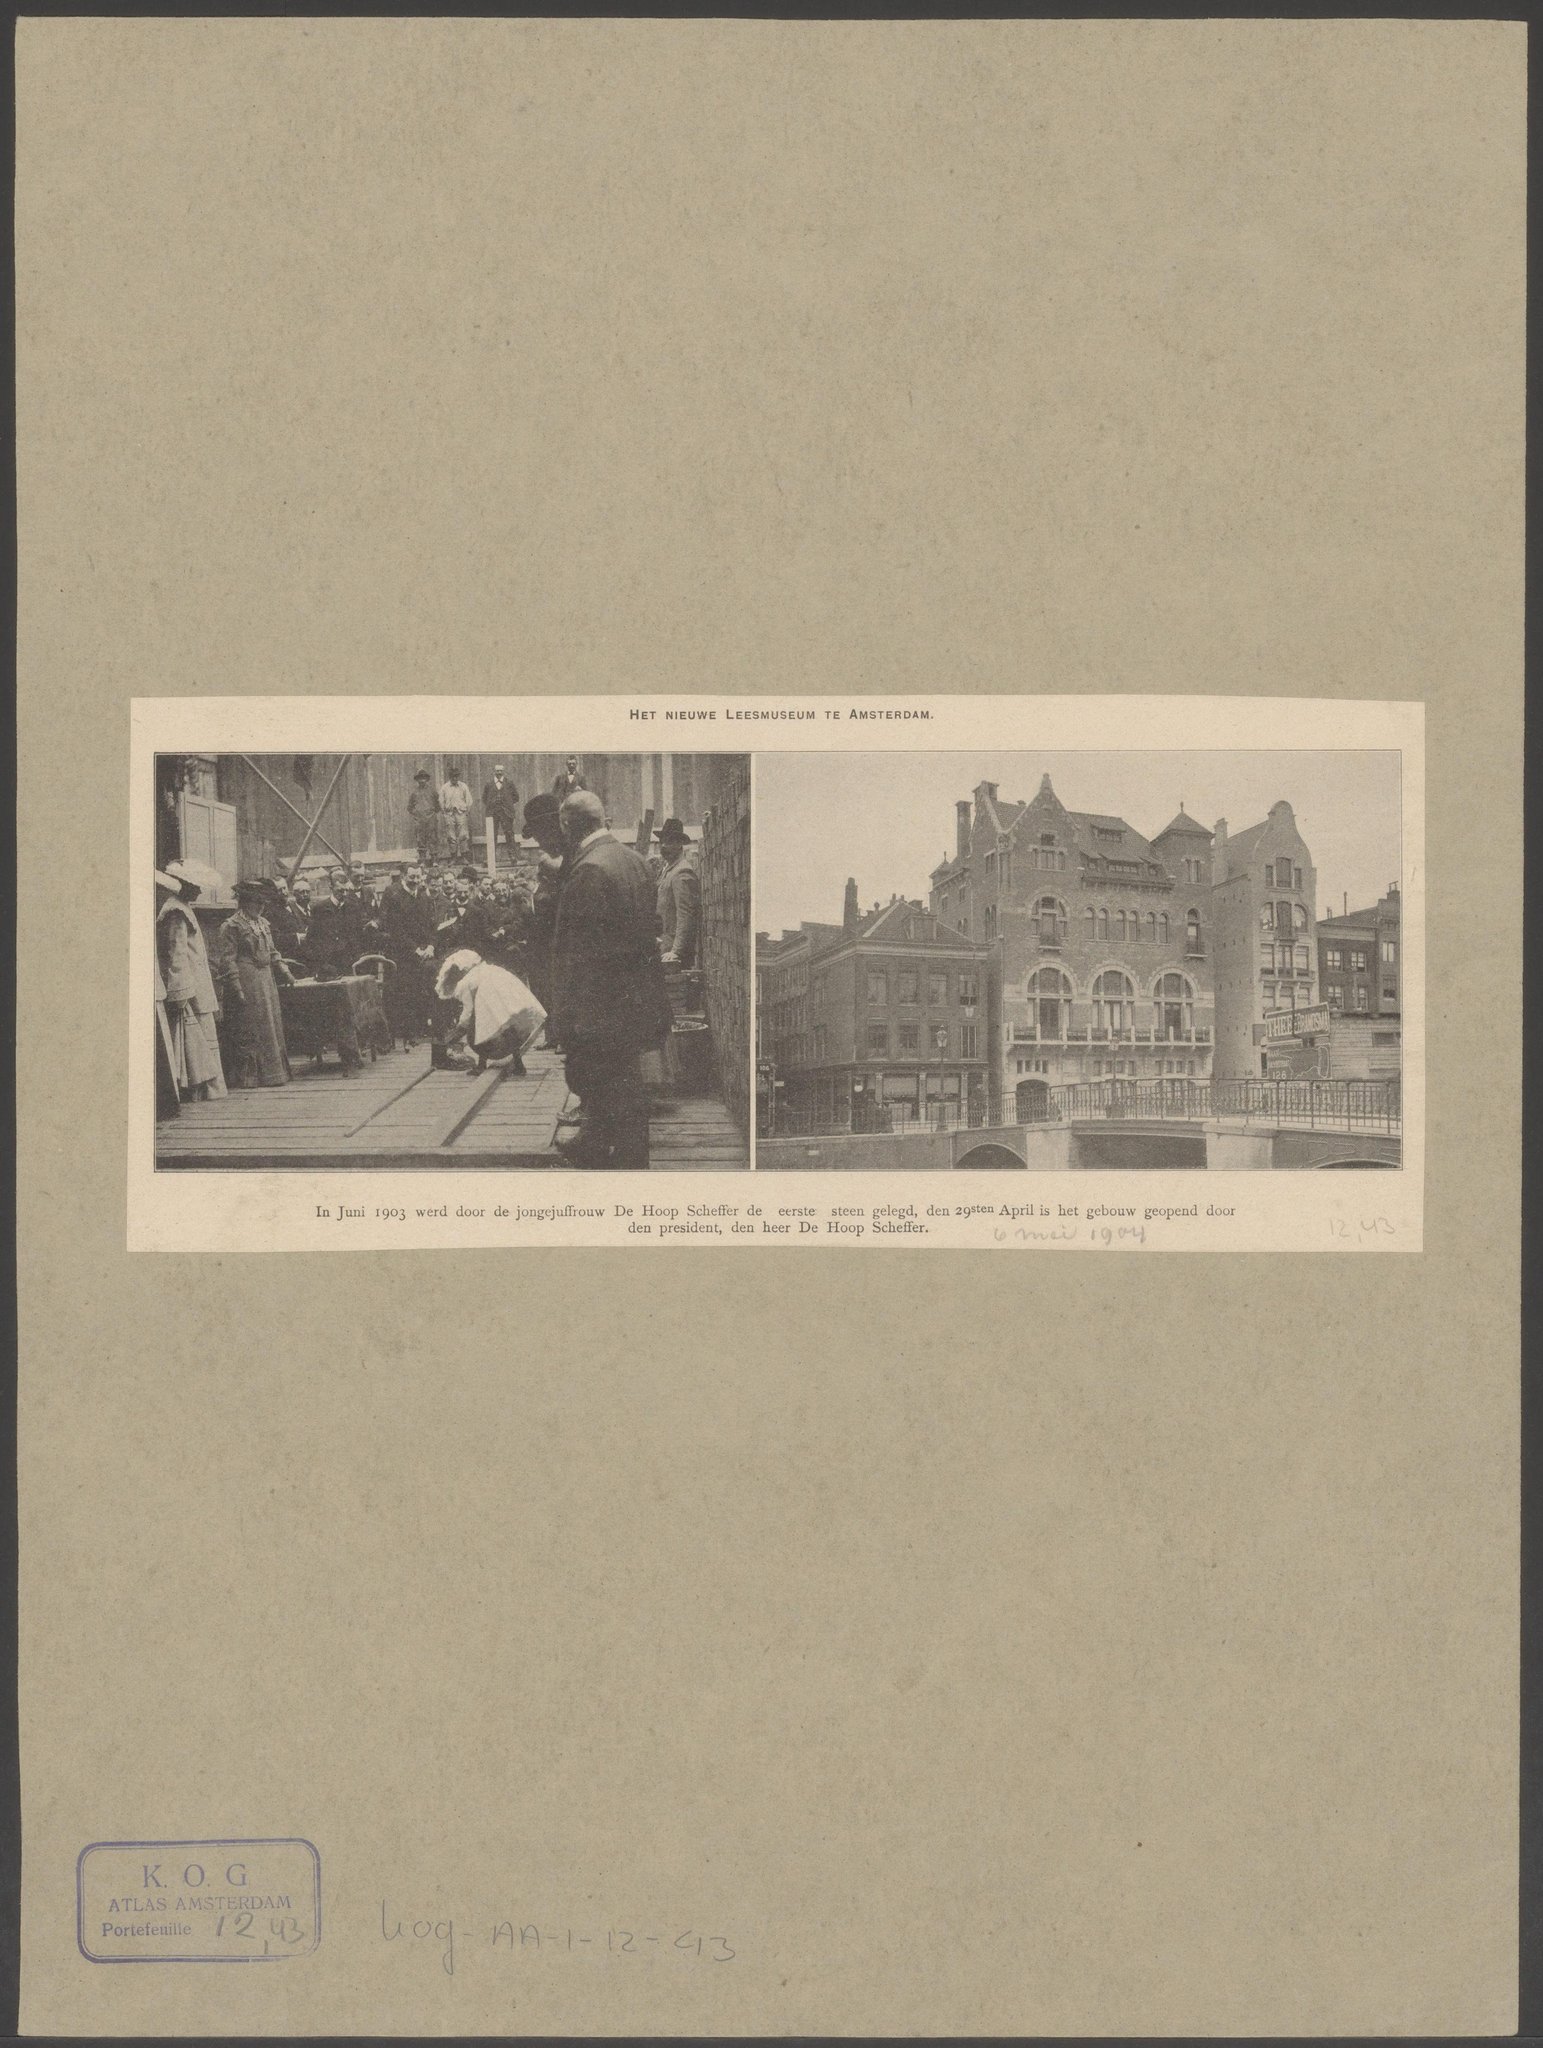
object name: photomechanical print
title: Gezicht op het Leesmuseum aan het Rokin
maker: Anonymous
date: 1904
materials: paper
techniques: letterpress printing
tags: city-view in general; 'veduta', canal, permanent exhibition, museum, façade (of house or building), bridge in city across river, canal, etc.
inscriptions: collector's mark: ‘12,43’ Lugt 1641b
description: Onderwerpsrubriek binnen de Atlas Amsterdam: Rokin, Rotterdammersloot, Rozengang, Rozengracht, Rozenstraat, Rusland, Rustenburgerstraat, Ruysdaelkade, Ruysdaelstraat, Ruyterkade (de), Ruyterweg (Admiraal de).